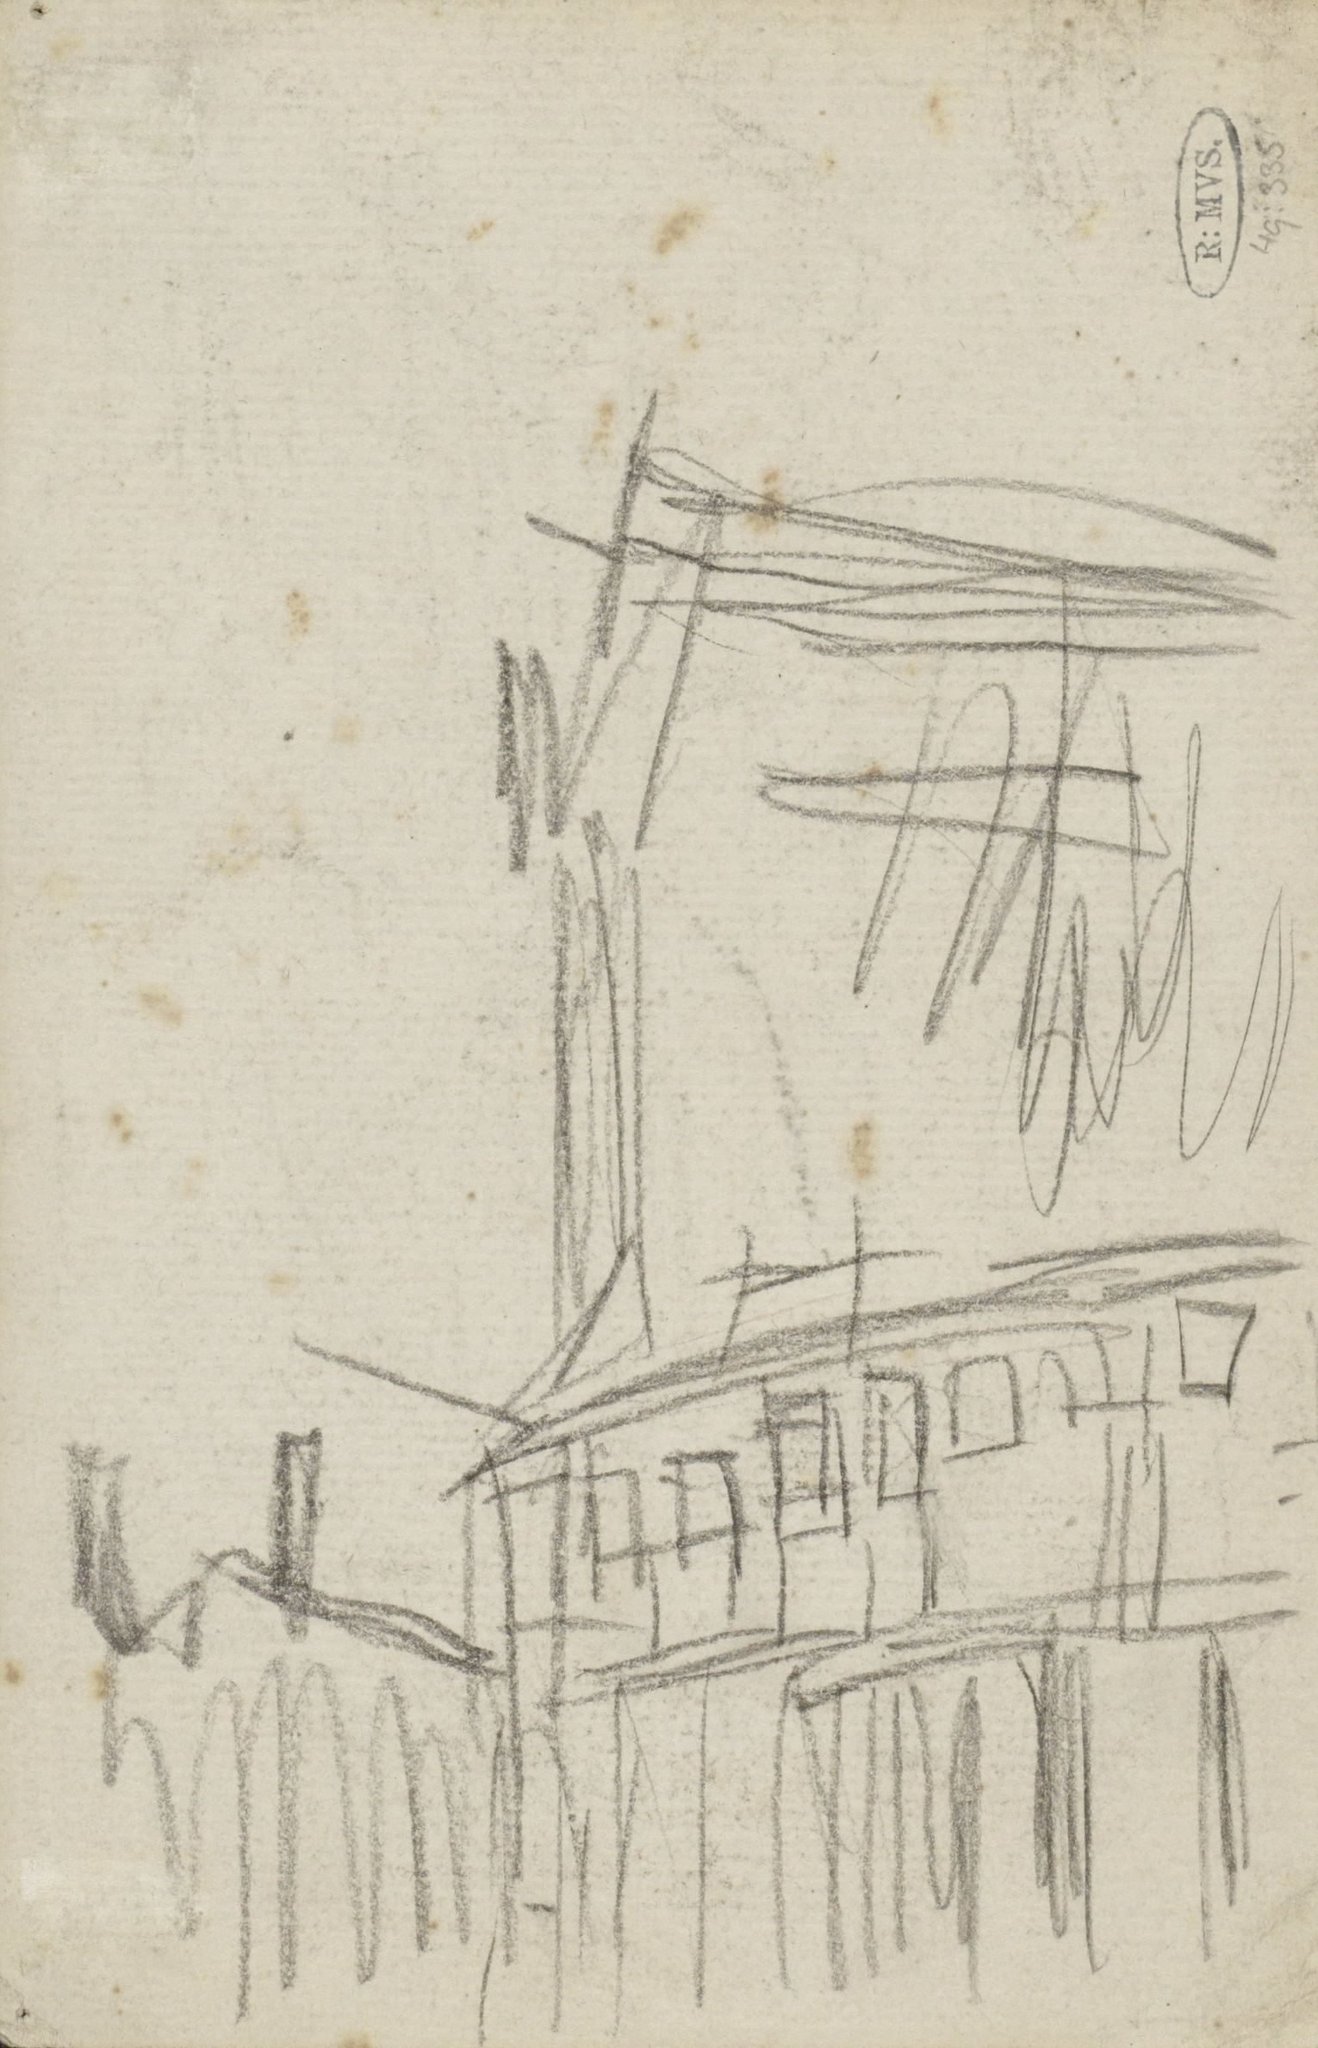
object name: drawing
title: Stadsgezicht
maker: george hendrik breitner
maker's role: draughtsman, painter, print maker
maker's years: 1857-1923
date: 1888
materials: chalk, paper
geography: amsterdam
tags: city-view, and landscape with man-made constructions, civic architecture; edifices; dwellings, amsterdam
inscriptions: collector's mark: Lugt 2228